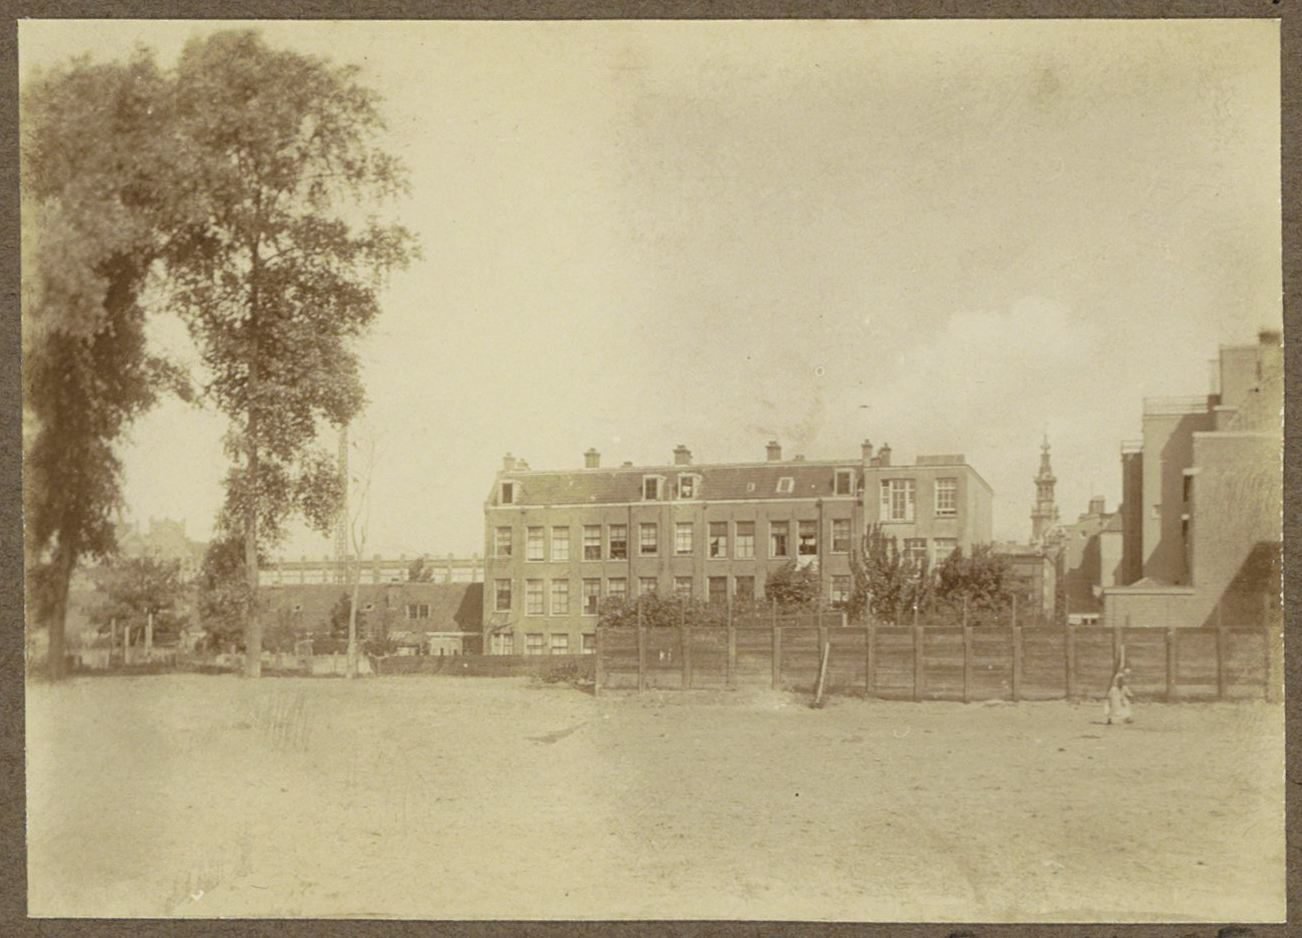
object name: photograph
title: Huizenrij en veld in de buurt van het Amsterdamse archiefgebouw aan de Amsteldijk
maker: Anonymous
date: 1914-1930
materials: paper, photographic support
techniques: daylight paper print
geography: amsterdam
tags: the usual house or row of houses, amsterdam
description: Onderdeel van Album met foto's van Amsterdam en omgeving.